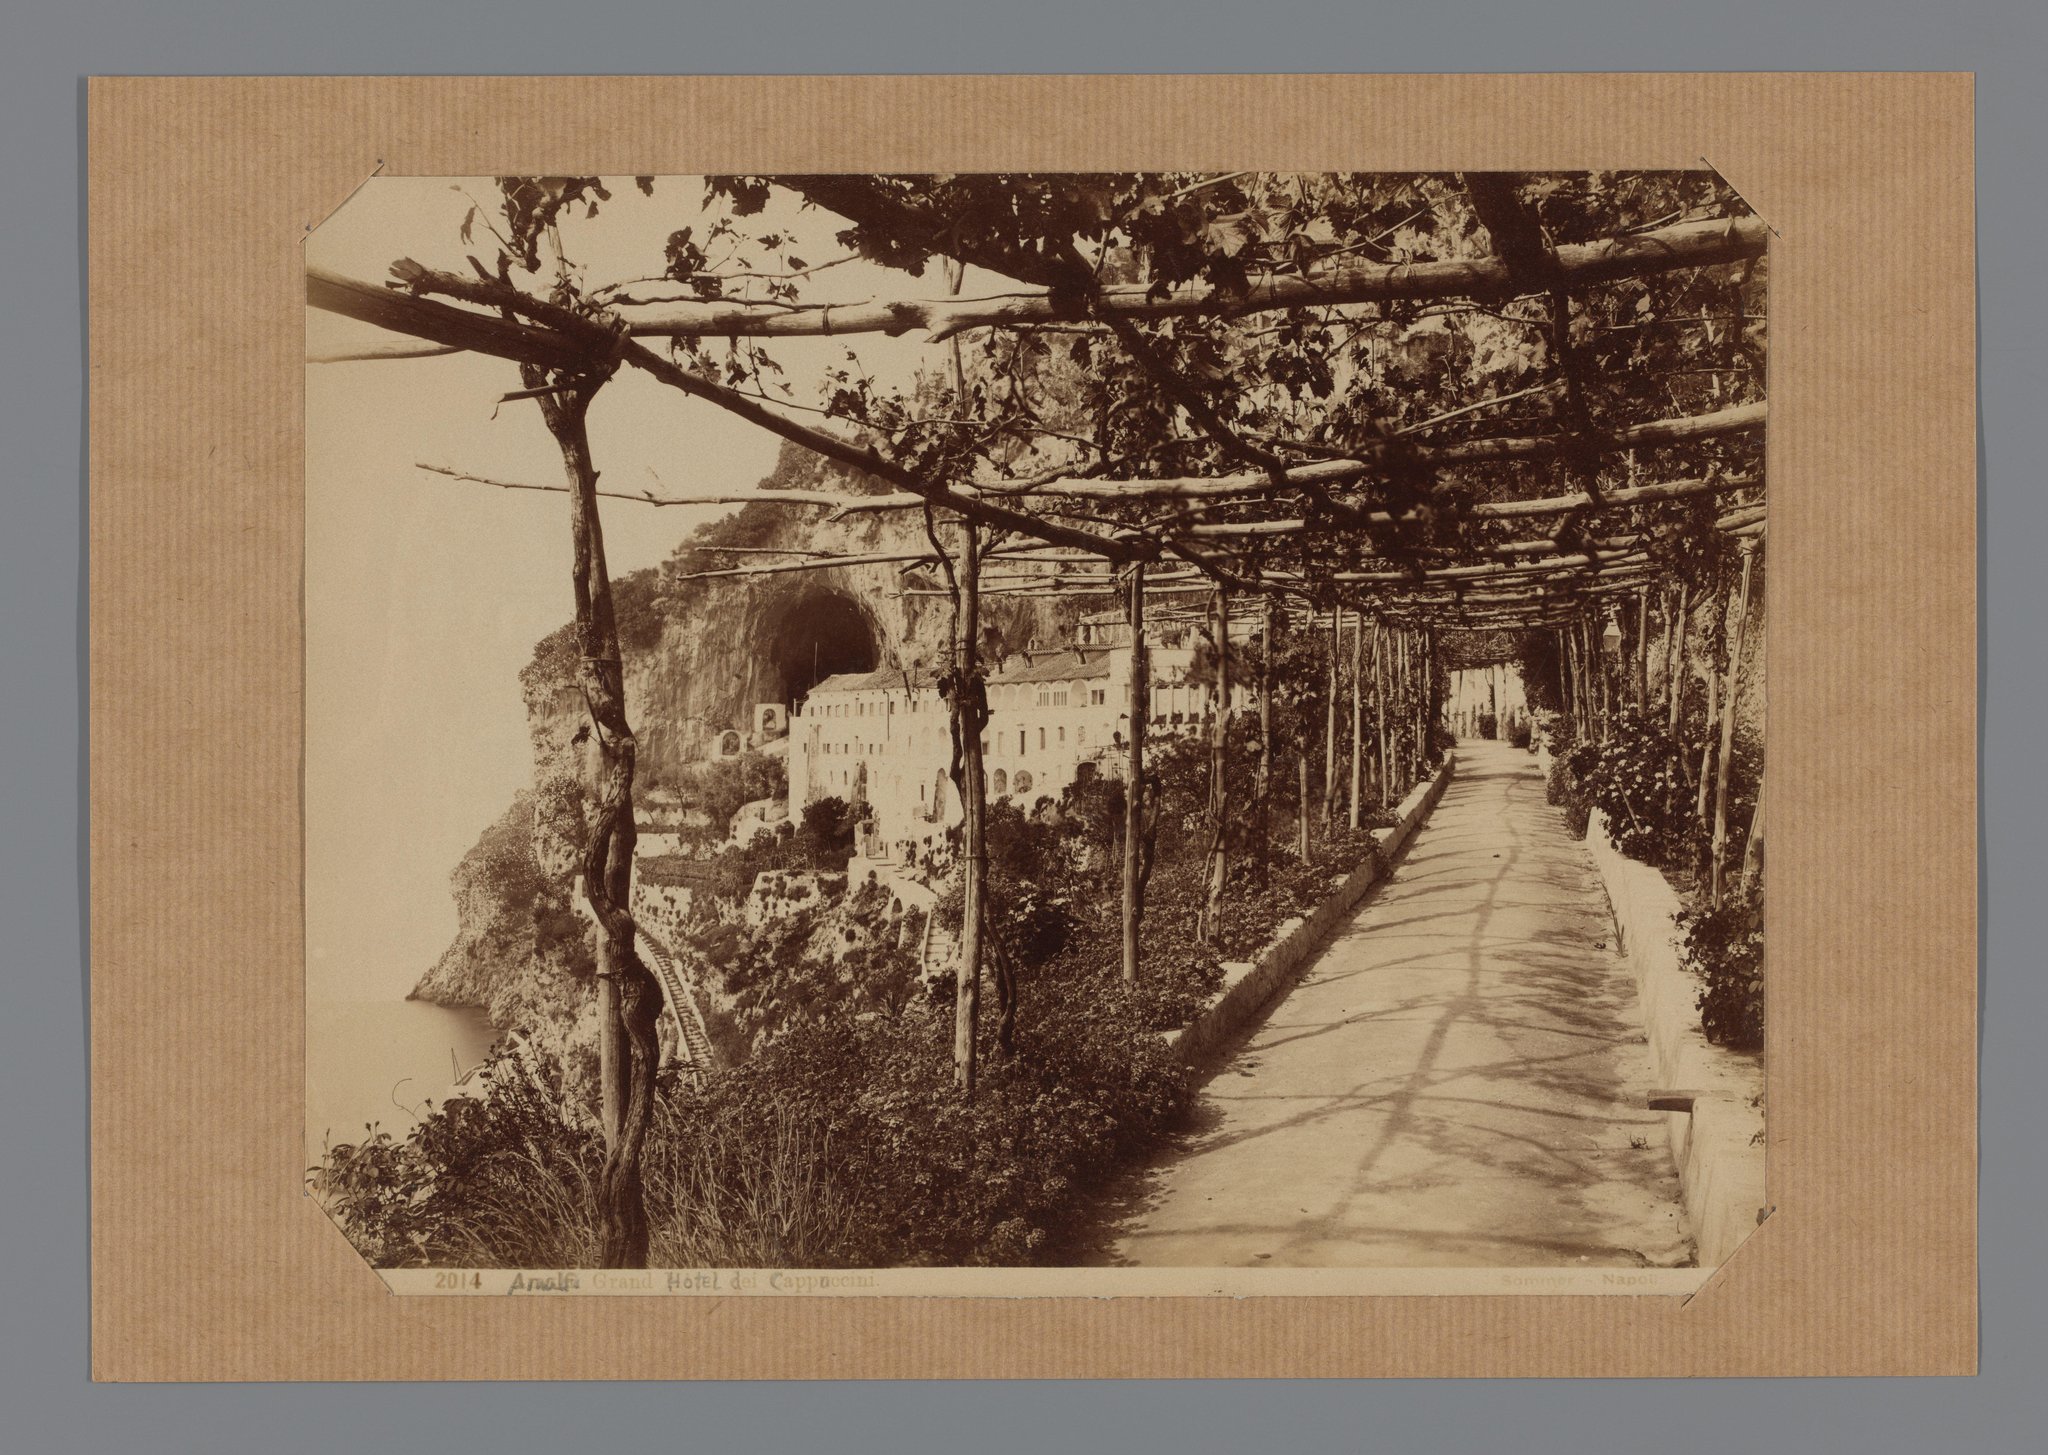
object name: photograph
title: Italië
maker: Anonymous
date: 1880-1910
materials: photographic support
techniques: albumen print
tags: italy